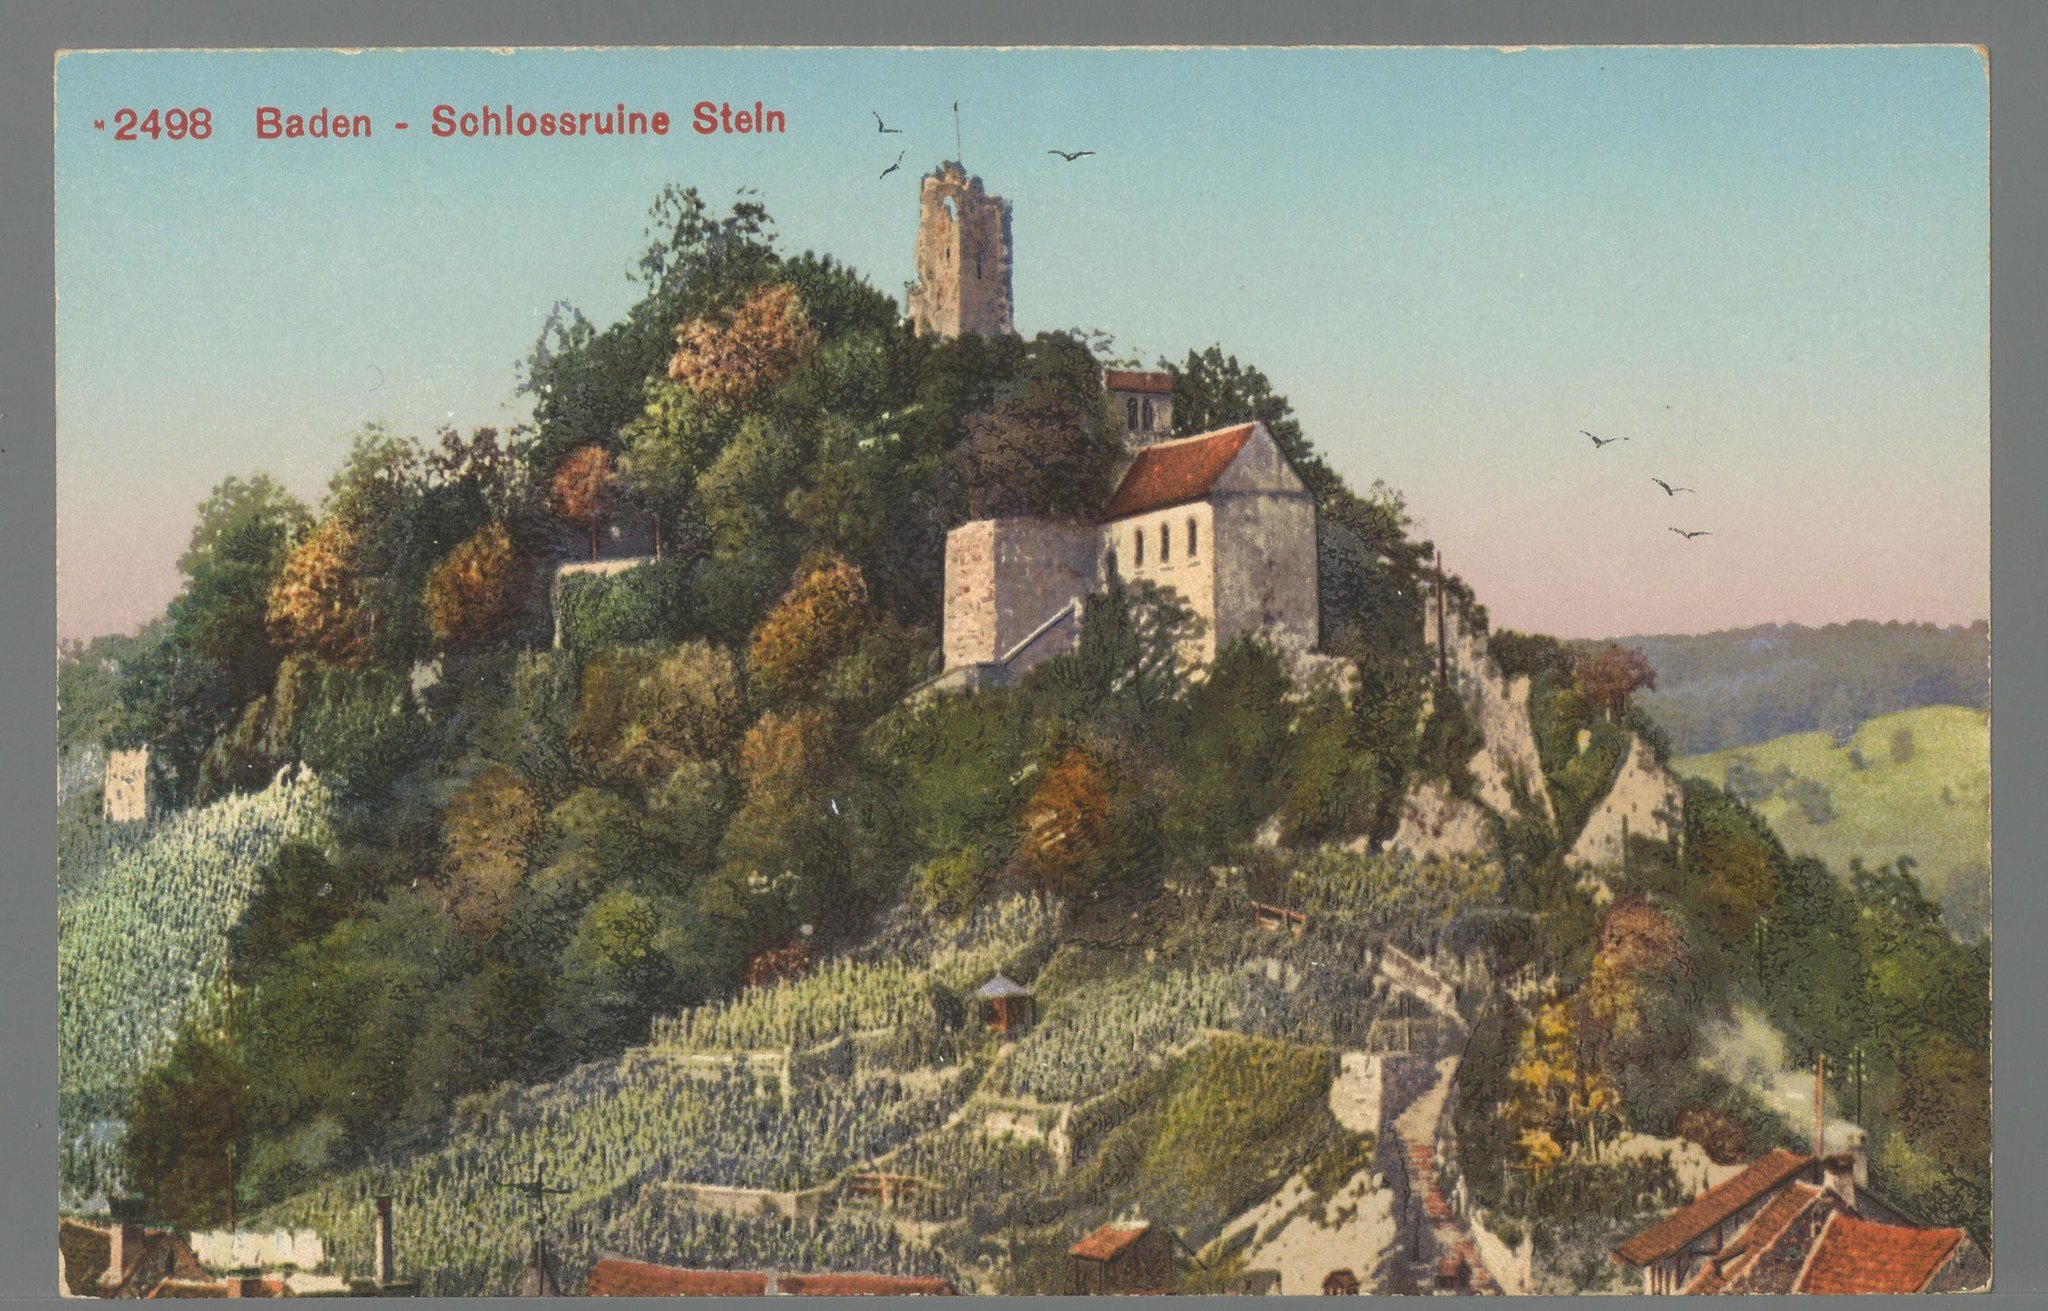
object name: photomechanical print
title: Baden. Schlossruine Stein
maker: Anonymous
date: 1905-1930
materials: cardboard, photographic process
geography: baden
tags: castle, landscape with ruins, mountains